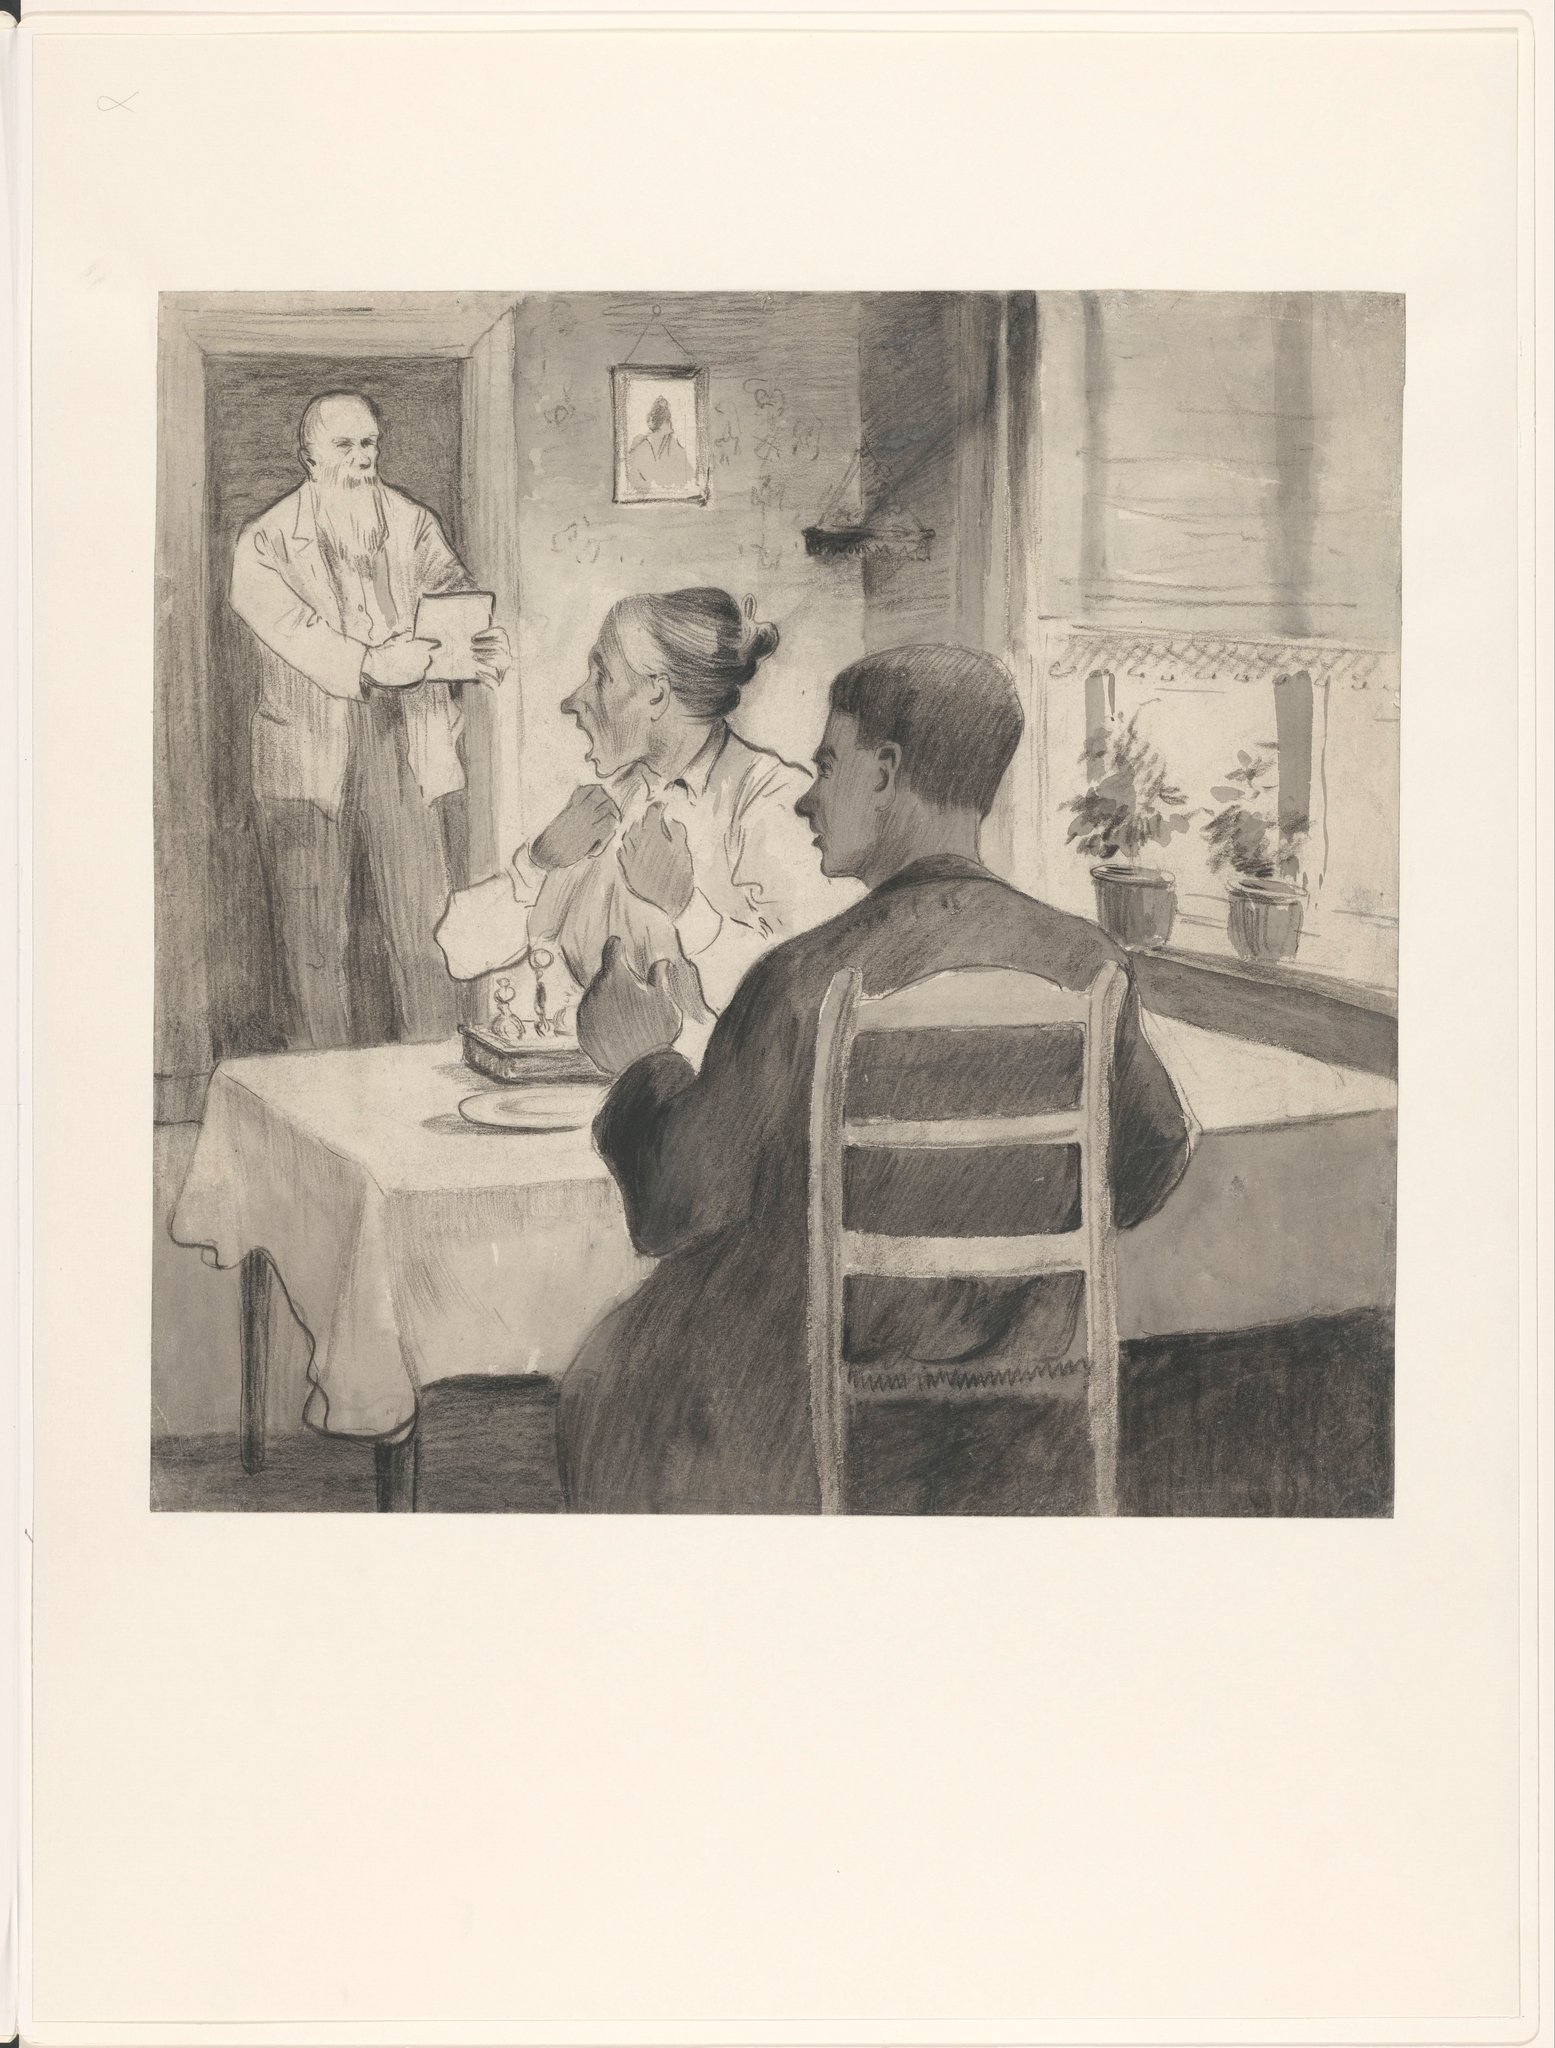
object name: drawing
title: Slecht nieuws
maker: jan de waardt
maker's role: draughtsman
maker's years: 1871-1909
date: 1875-1900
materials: chalk, paper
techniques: brush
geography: netherlands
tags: family life at home, netherlands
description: Op de voorgrond op de rug gezien een jongeman aan tafel, tegenover hem links zit een oudere vrouw met verbijsterde gelaatsuitdrukking. Links achter de vrouw voor een deuropening staat een kalende man met witte baard die met twee handen een vel papier voor zich houdt. Rechts een raam met zonnescherm half dicht.